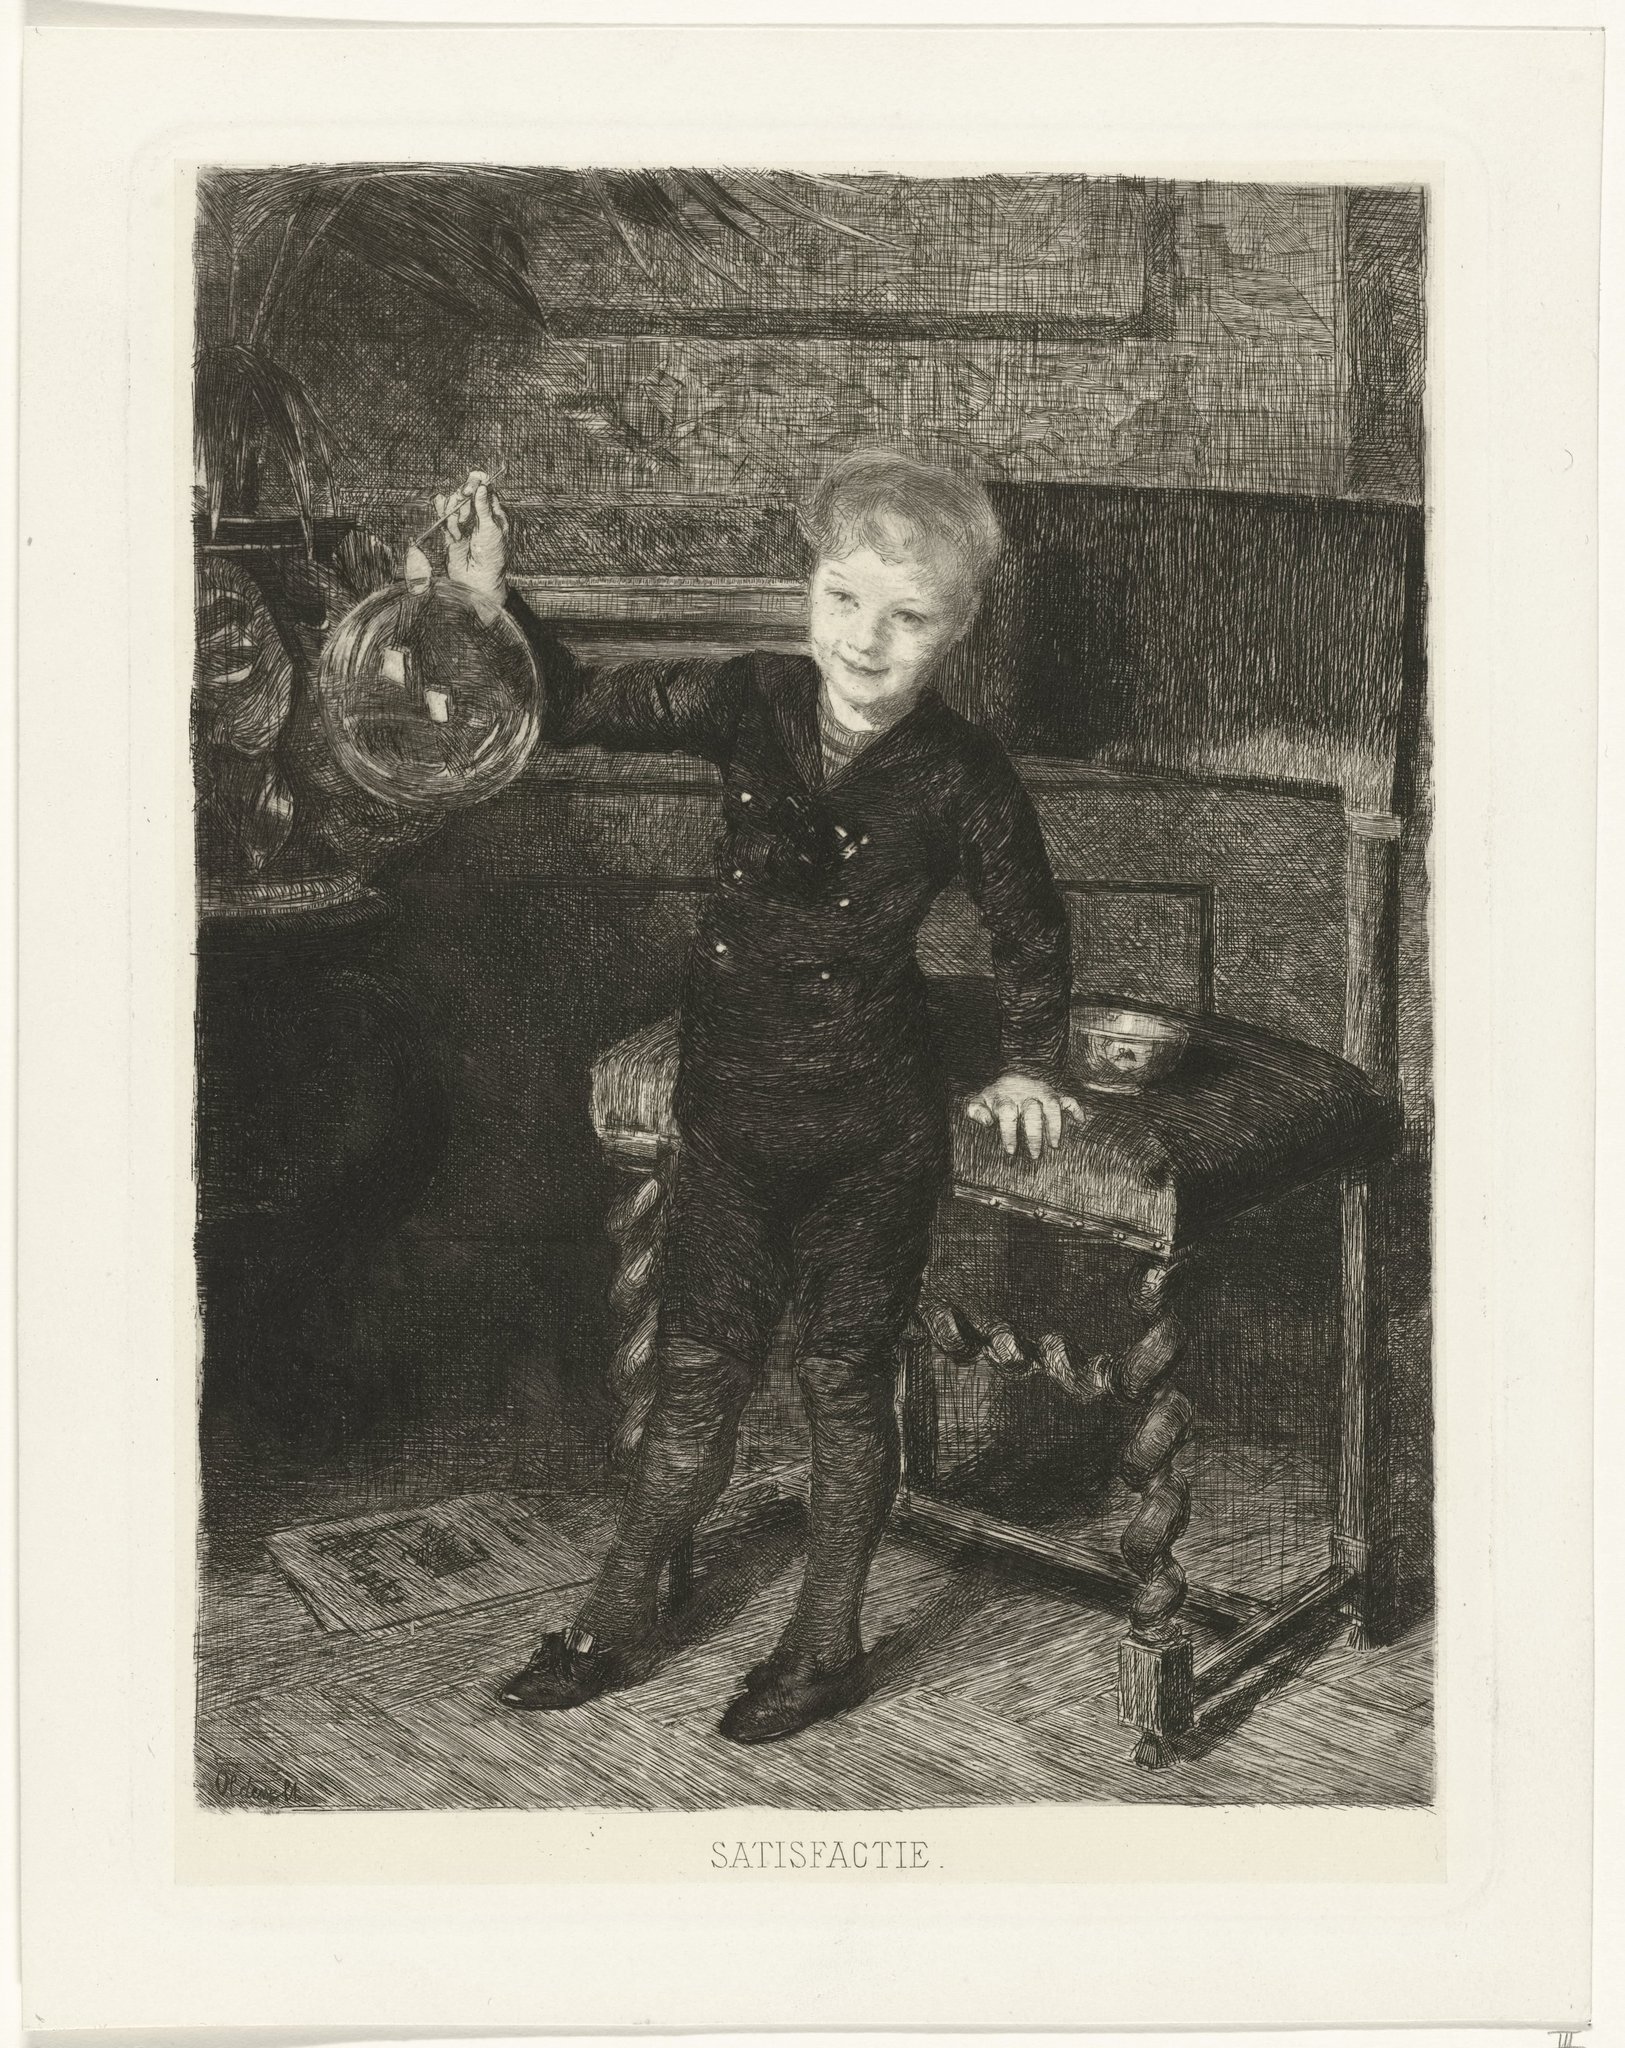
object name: print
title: Bellenblazend jongetje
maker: ferdinand oldewelt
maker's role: draughtsman, print maker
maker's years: 1857-1935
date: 1887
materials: paper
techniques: drypoint, etching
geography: netherlands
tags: bubble-blowing (children's games and plays)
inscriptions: collector's mark: Lugt 2228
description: Portret van F.W.C.H. Oldewelt, zoon van de kunstenaar, als kind. Het jongetje leunt tegen een gestoffeerde stoel en toont trots een grote bel.